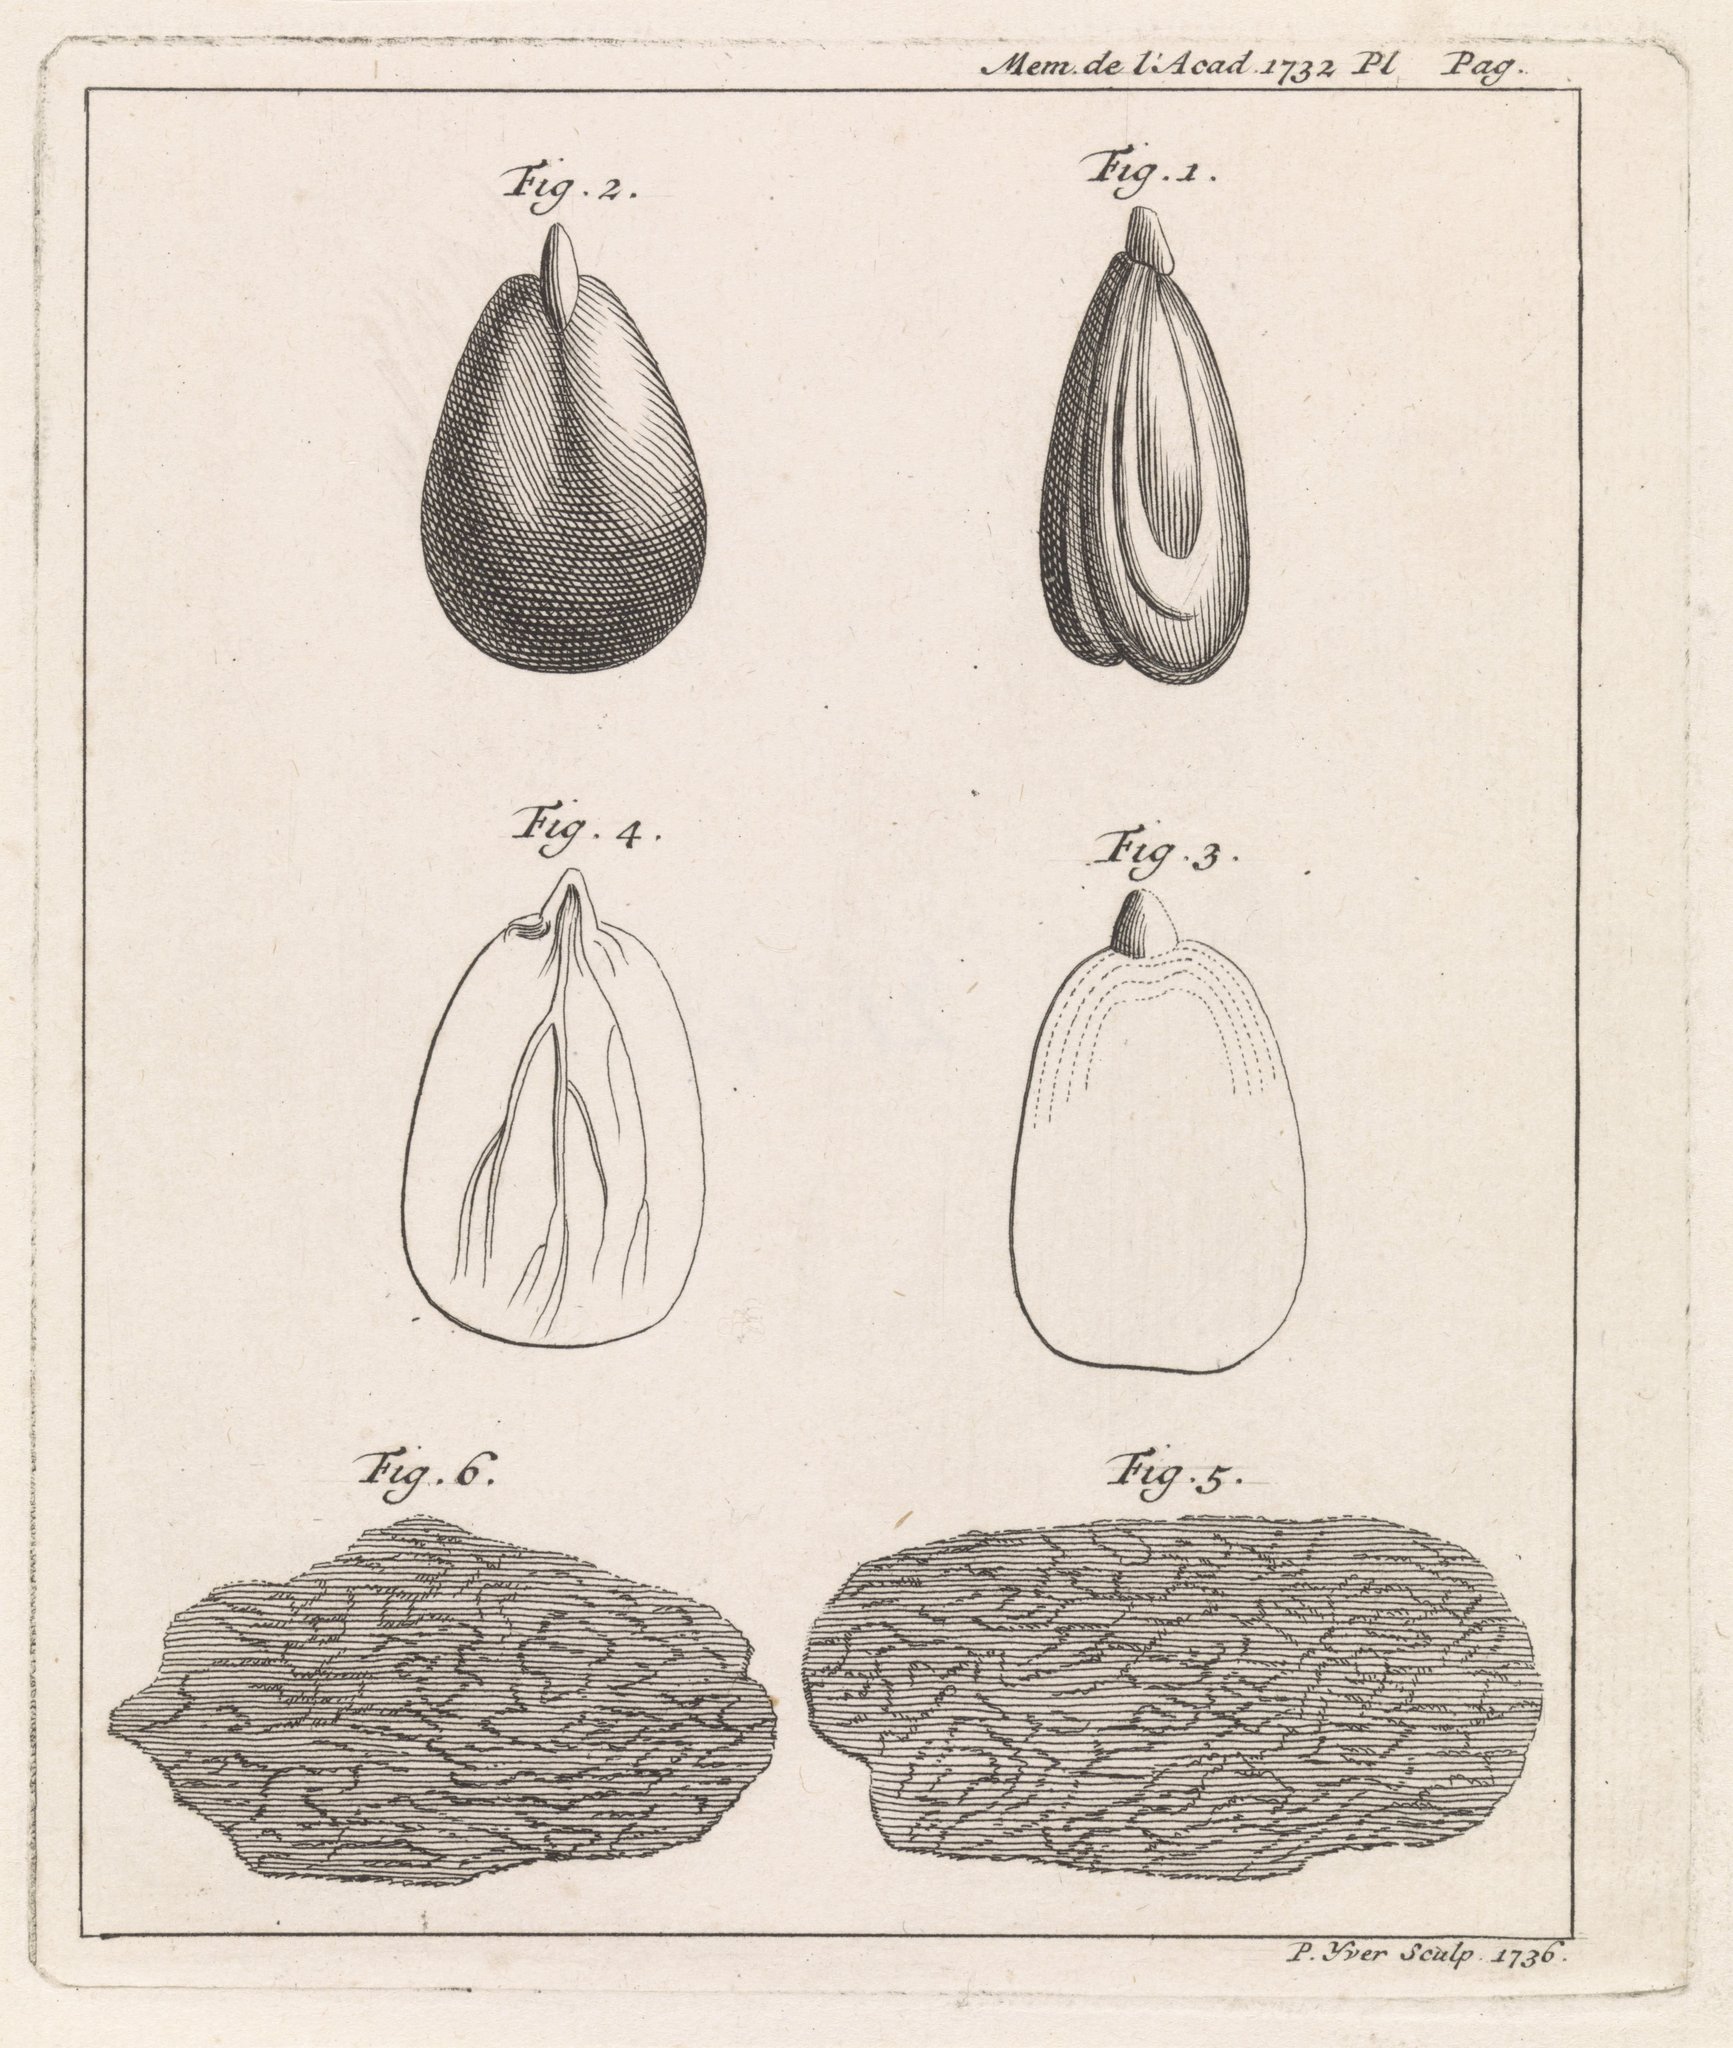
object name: book illustration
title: Plantenzaad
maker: pieter yver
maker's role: print maker, publisher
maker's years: 1712-1787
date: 1736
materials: paper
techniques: engraving, etching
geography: amsterdam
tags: seed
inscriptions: collector's mark: Lugt 2233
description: Verschillende figuren en doorsneden van een kiemend plantenzaadje,1 t/m 6 genummerd.